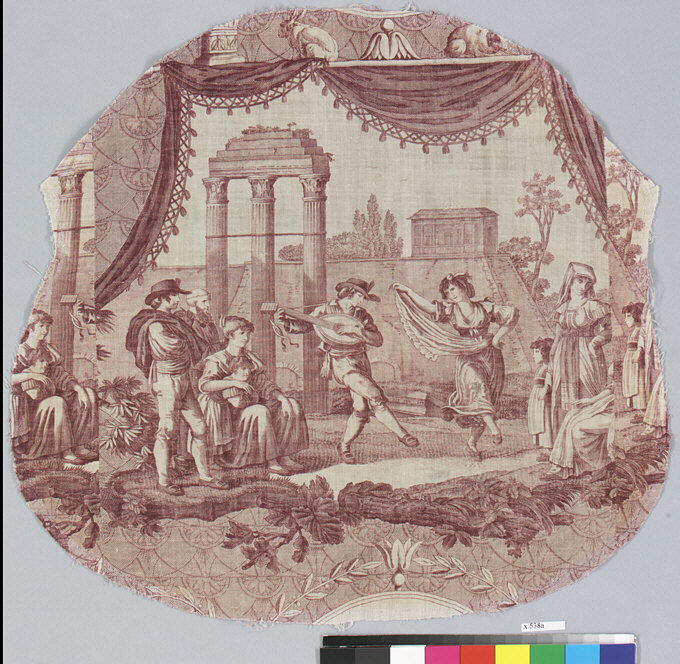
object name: piece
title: Scènes romaines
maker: bartolomeo penelli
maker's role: designer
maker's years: 1750-1850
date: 1811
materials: cotton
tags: men,women,dancing,musicians